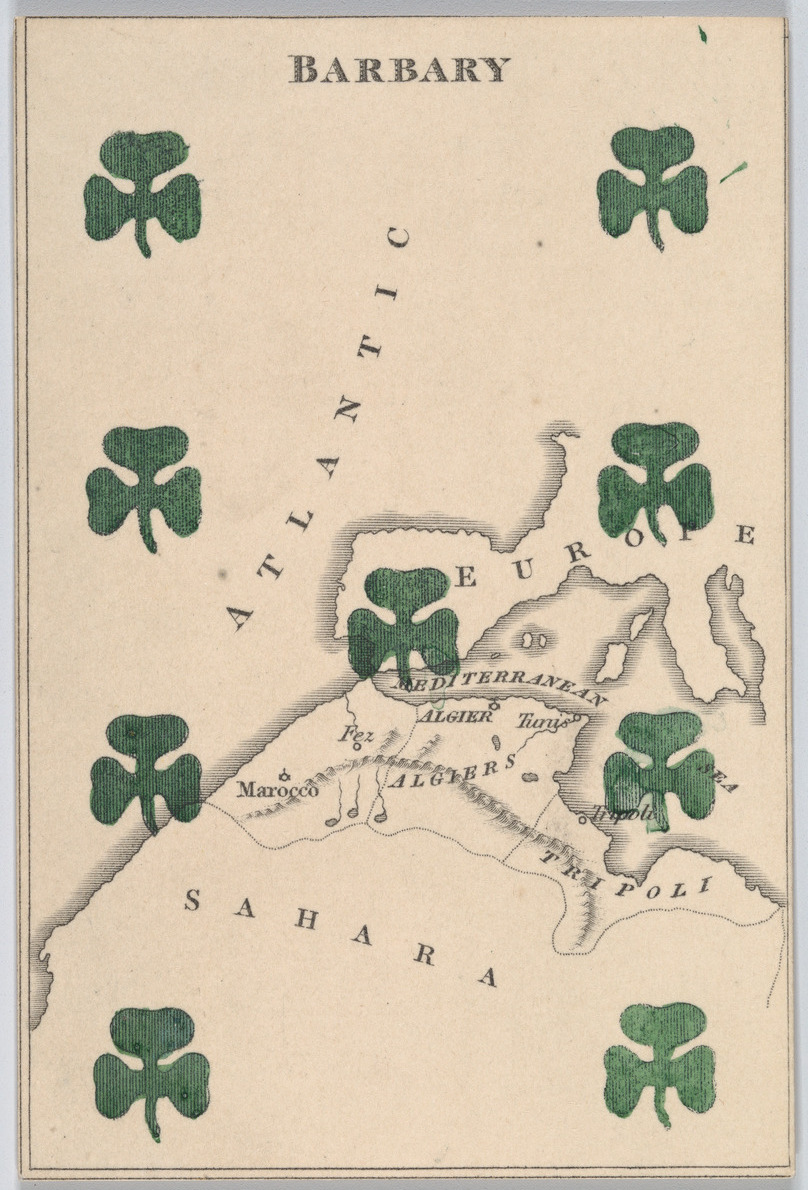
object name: print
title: Barbary, from "Court Game of Geography"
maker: william and henry rock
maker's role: publisher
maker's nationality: british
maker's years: 1821-1884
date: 1838-1855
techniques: engraving, hand coloring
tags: playing cards,maps